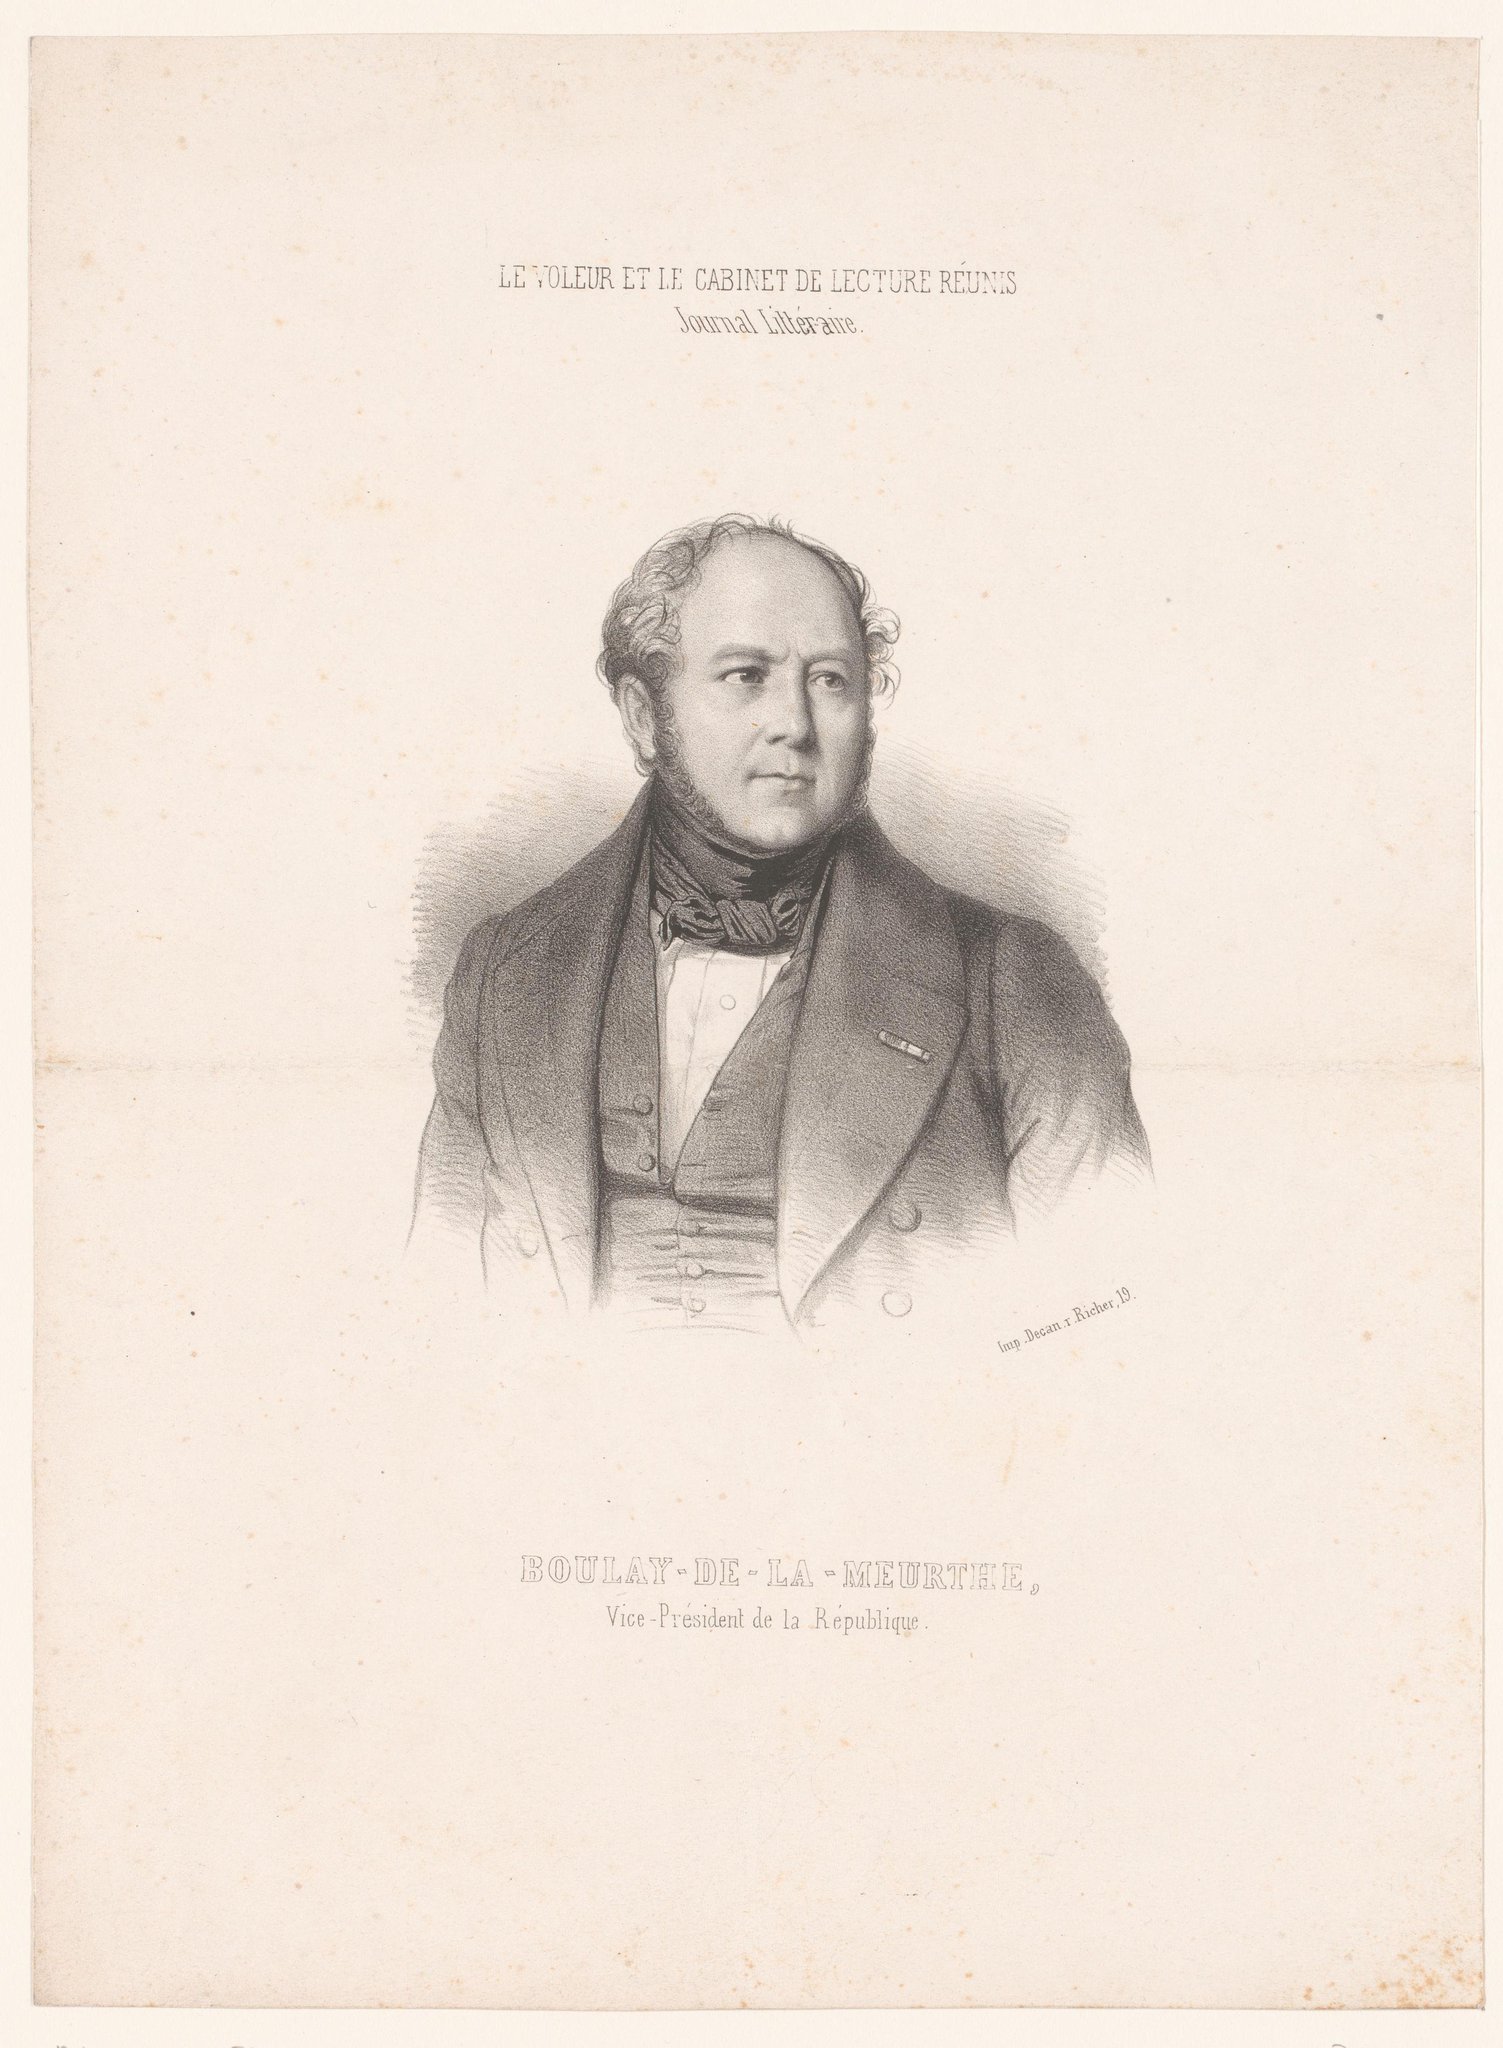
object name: print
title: Portret van vicepresident Henri Boulay de La Meurthe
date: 1849-1852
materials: paper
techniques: lithograph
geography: paris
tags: historical persons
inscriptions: collector's mark: Lugt 2228a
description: Prent gebruikt voor: Le Voleur et Le Cabinet de Lecture réunis. Journal littéraire, 1842-1856.